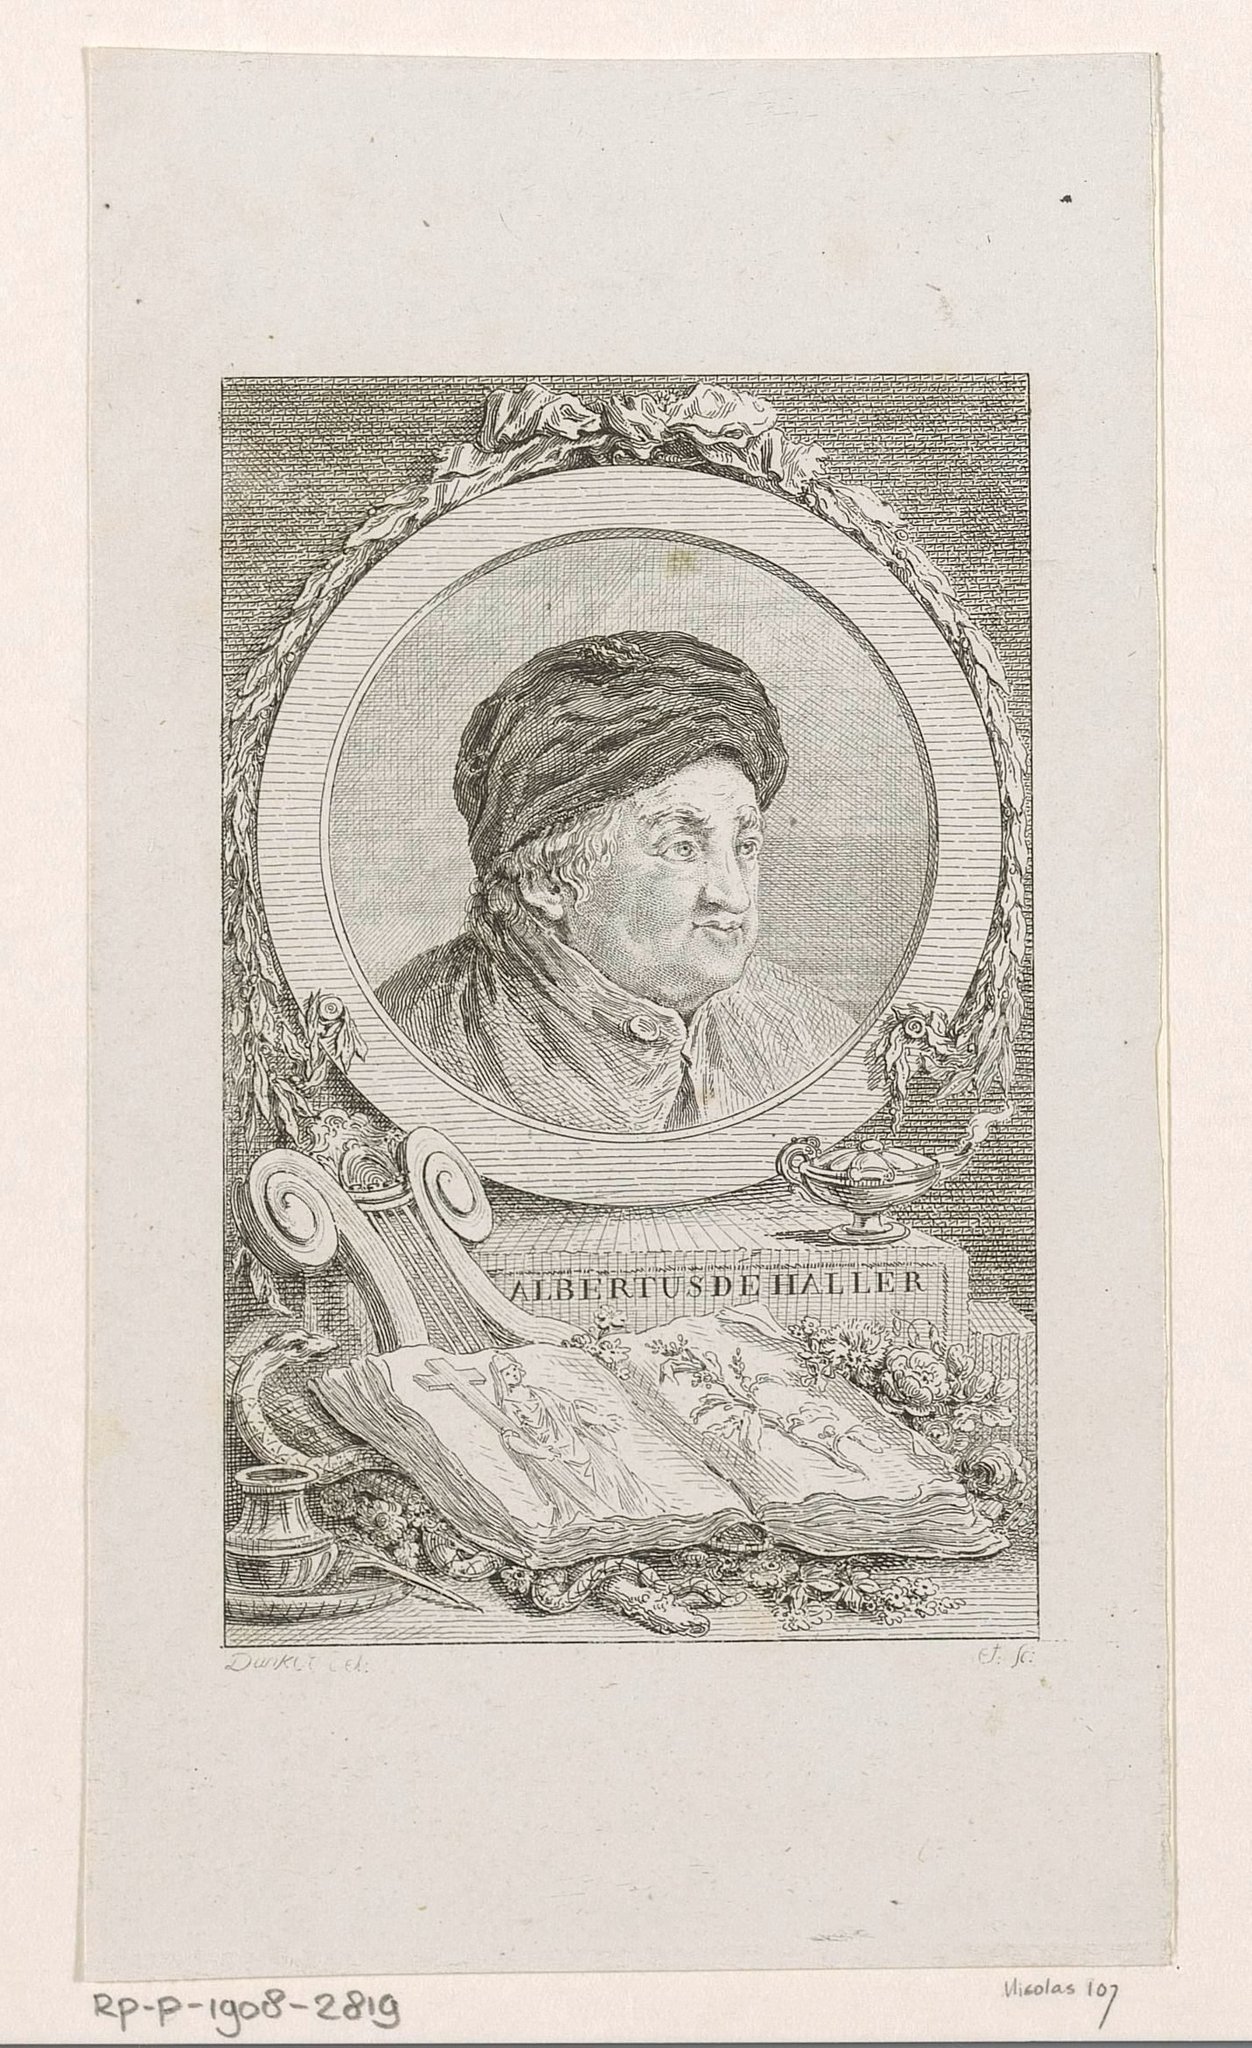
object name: print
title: Portret van Albrecht von Haller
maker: balthasar anton dunker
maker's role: draughtsman, print maker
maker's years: 1746-1807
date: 1777-1807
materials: paper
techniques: etching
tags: physicist, herbarium, lyre, cithara, psaltery, attributes of aesculapius: rod and serpent, ornament ~ medallion, historical persons, book - mm - book open, writing accessories, female saints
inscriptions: collector's mark: Lugt 2228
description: Prent gebruikt voor: Haller, Albrecht von. Des Herrn von Hallers Tagebuch der medicinischen Litteratur der Jahre 1745 bis 1774. 2 dln. Bern: s.n., 1789-1790.